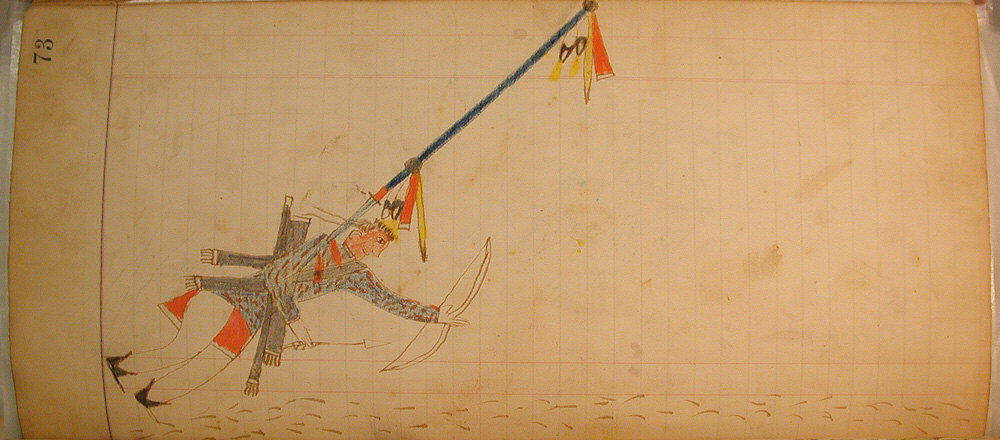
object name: drawing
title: Maffet Ledger: Drawing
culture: cheyenne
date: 1874-1881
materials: crayon, graphite, paper, watercolor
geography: united states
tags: bow and arrow,men